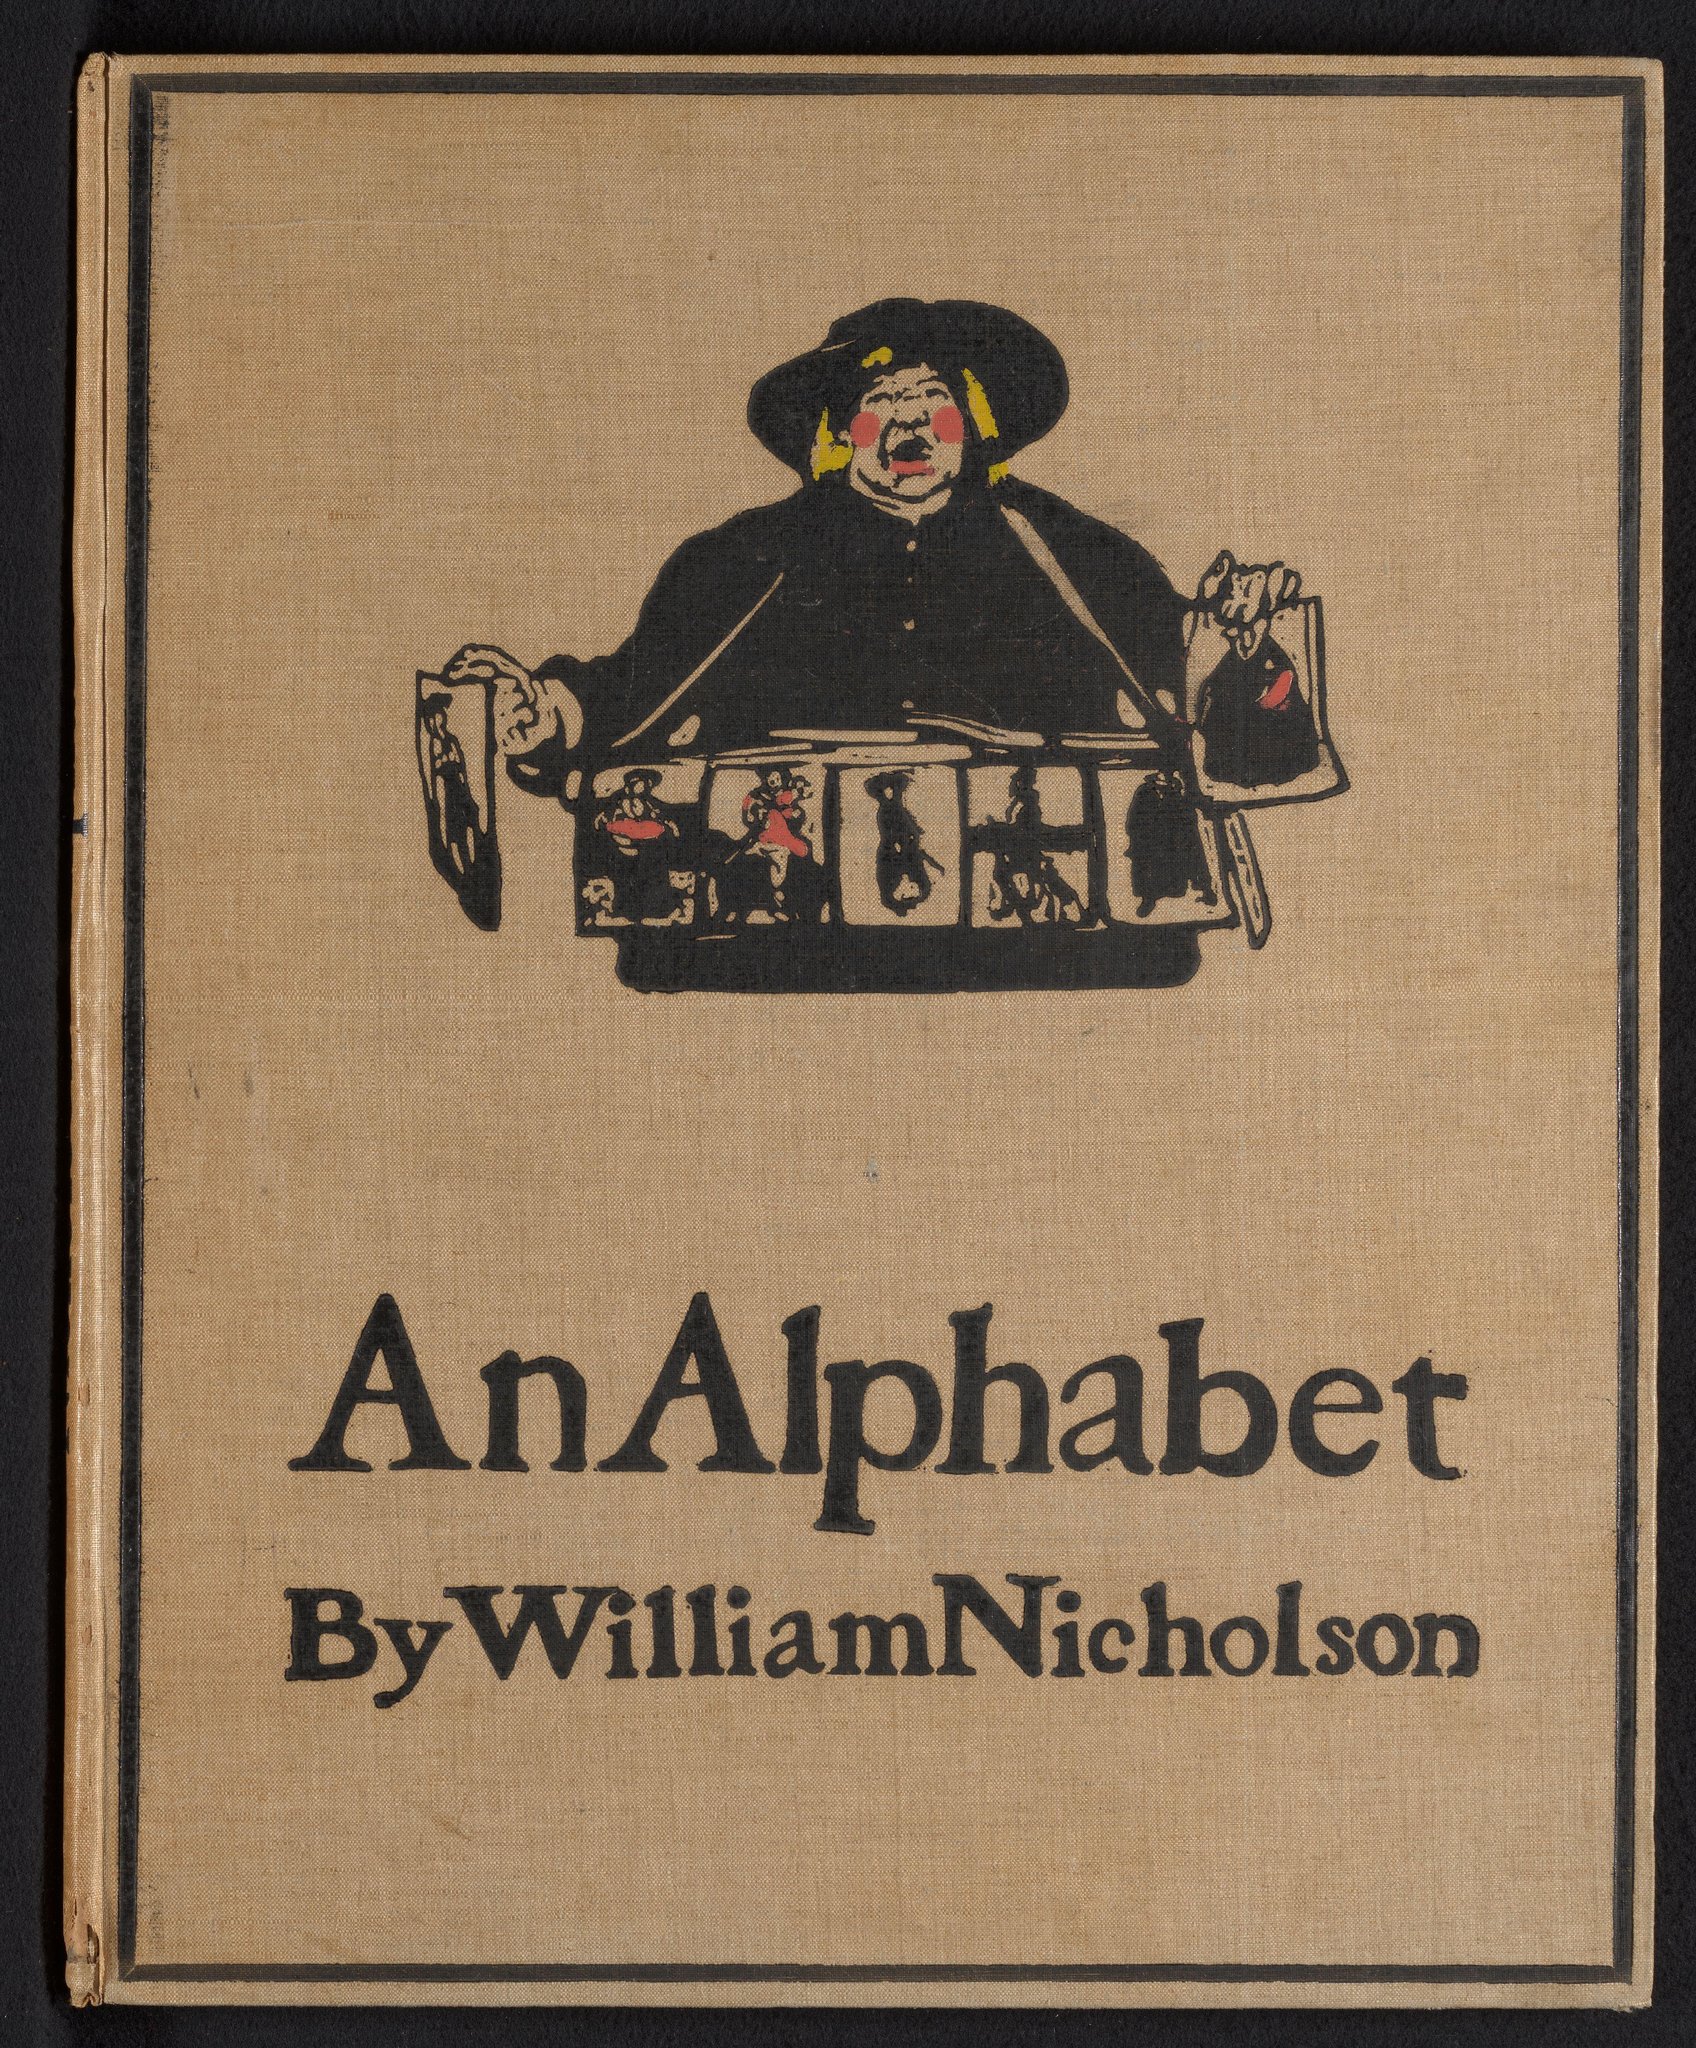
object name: book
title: An Alphabet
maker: william heinemann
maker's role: publisher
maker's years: 1863-1920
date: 1898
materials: cardboard, linen, paper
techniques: bookbinding, lithograph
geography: london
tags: letters, alphabet, script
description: Verkoper op voorplat en een molen met de initialen W. H. op het achterplat. Boek met een ex libris, een titelprent en 26 lithografieën.